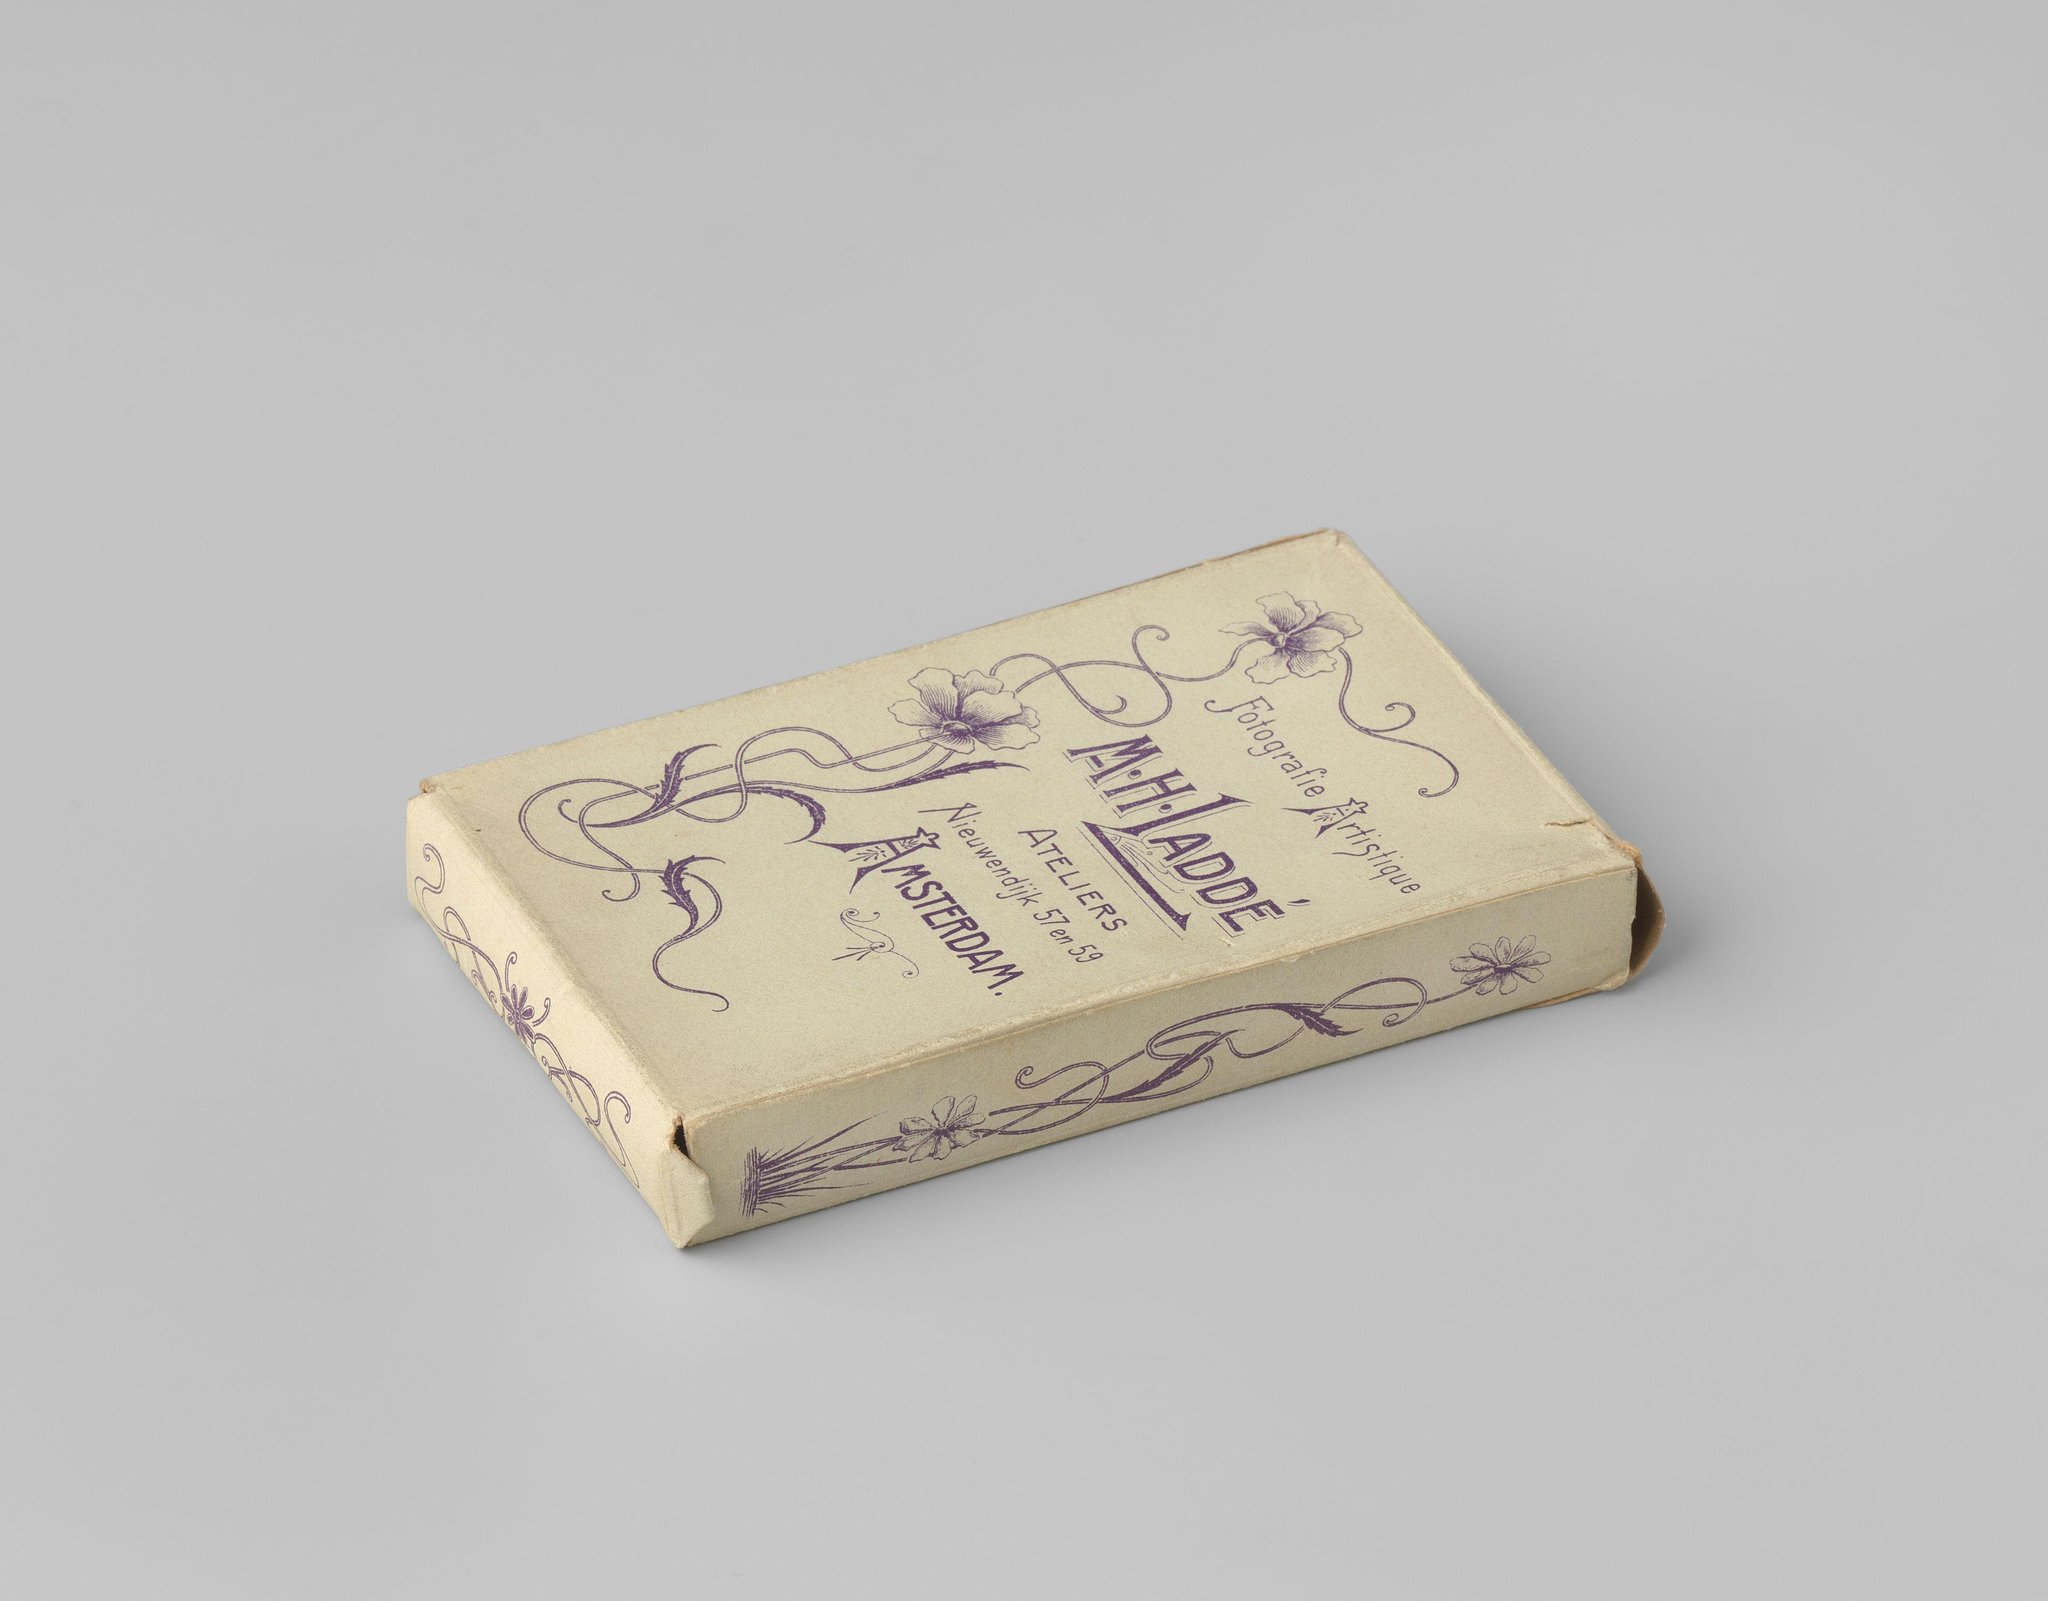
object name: verpakking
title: Verpakking voor één lege vloeipapieren hoes en twee vloeipapieren hoezen met daarin twee cartes-de-visite gemaakt door M.H. Laddé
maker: machiel hendricus laddé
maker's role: fotograaf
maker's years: 1866-1932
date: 1911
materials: cardboard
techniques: lithograph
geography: amsterdam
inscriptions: inscription: ‘Fotografie Artistique/ M.H. Laddé/ Ateliers/ Nieuwendijk 57 en 59/ Amsterdam.’, inscription: ‘28 zoz [?]/ Hanse [?]’, date: ‘29 apr 1911’